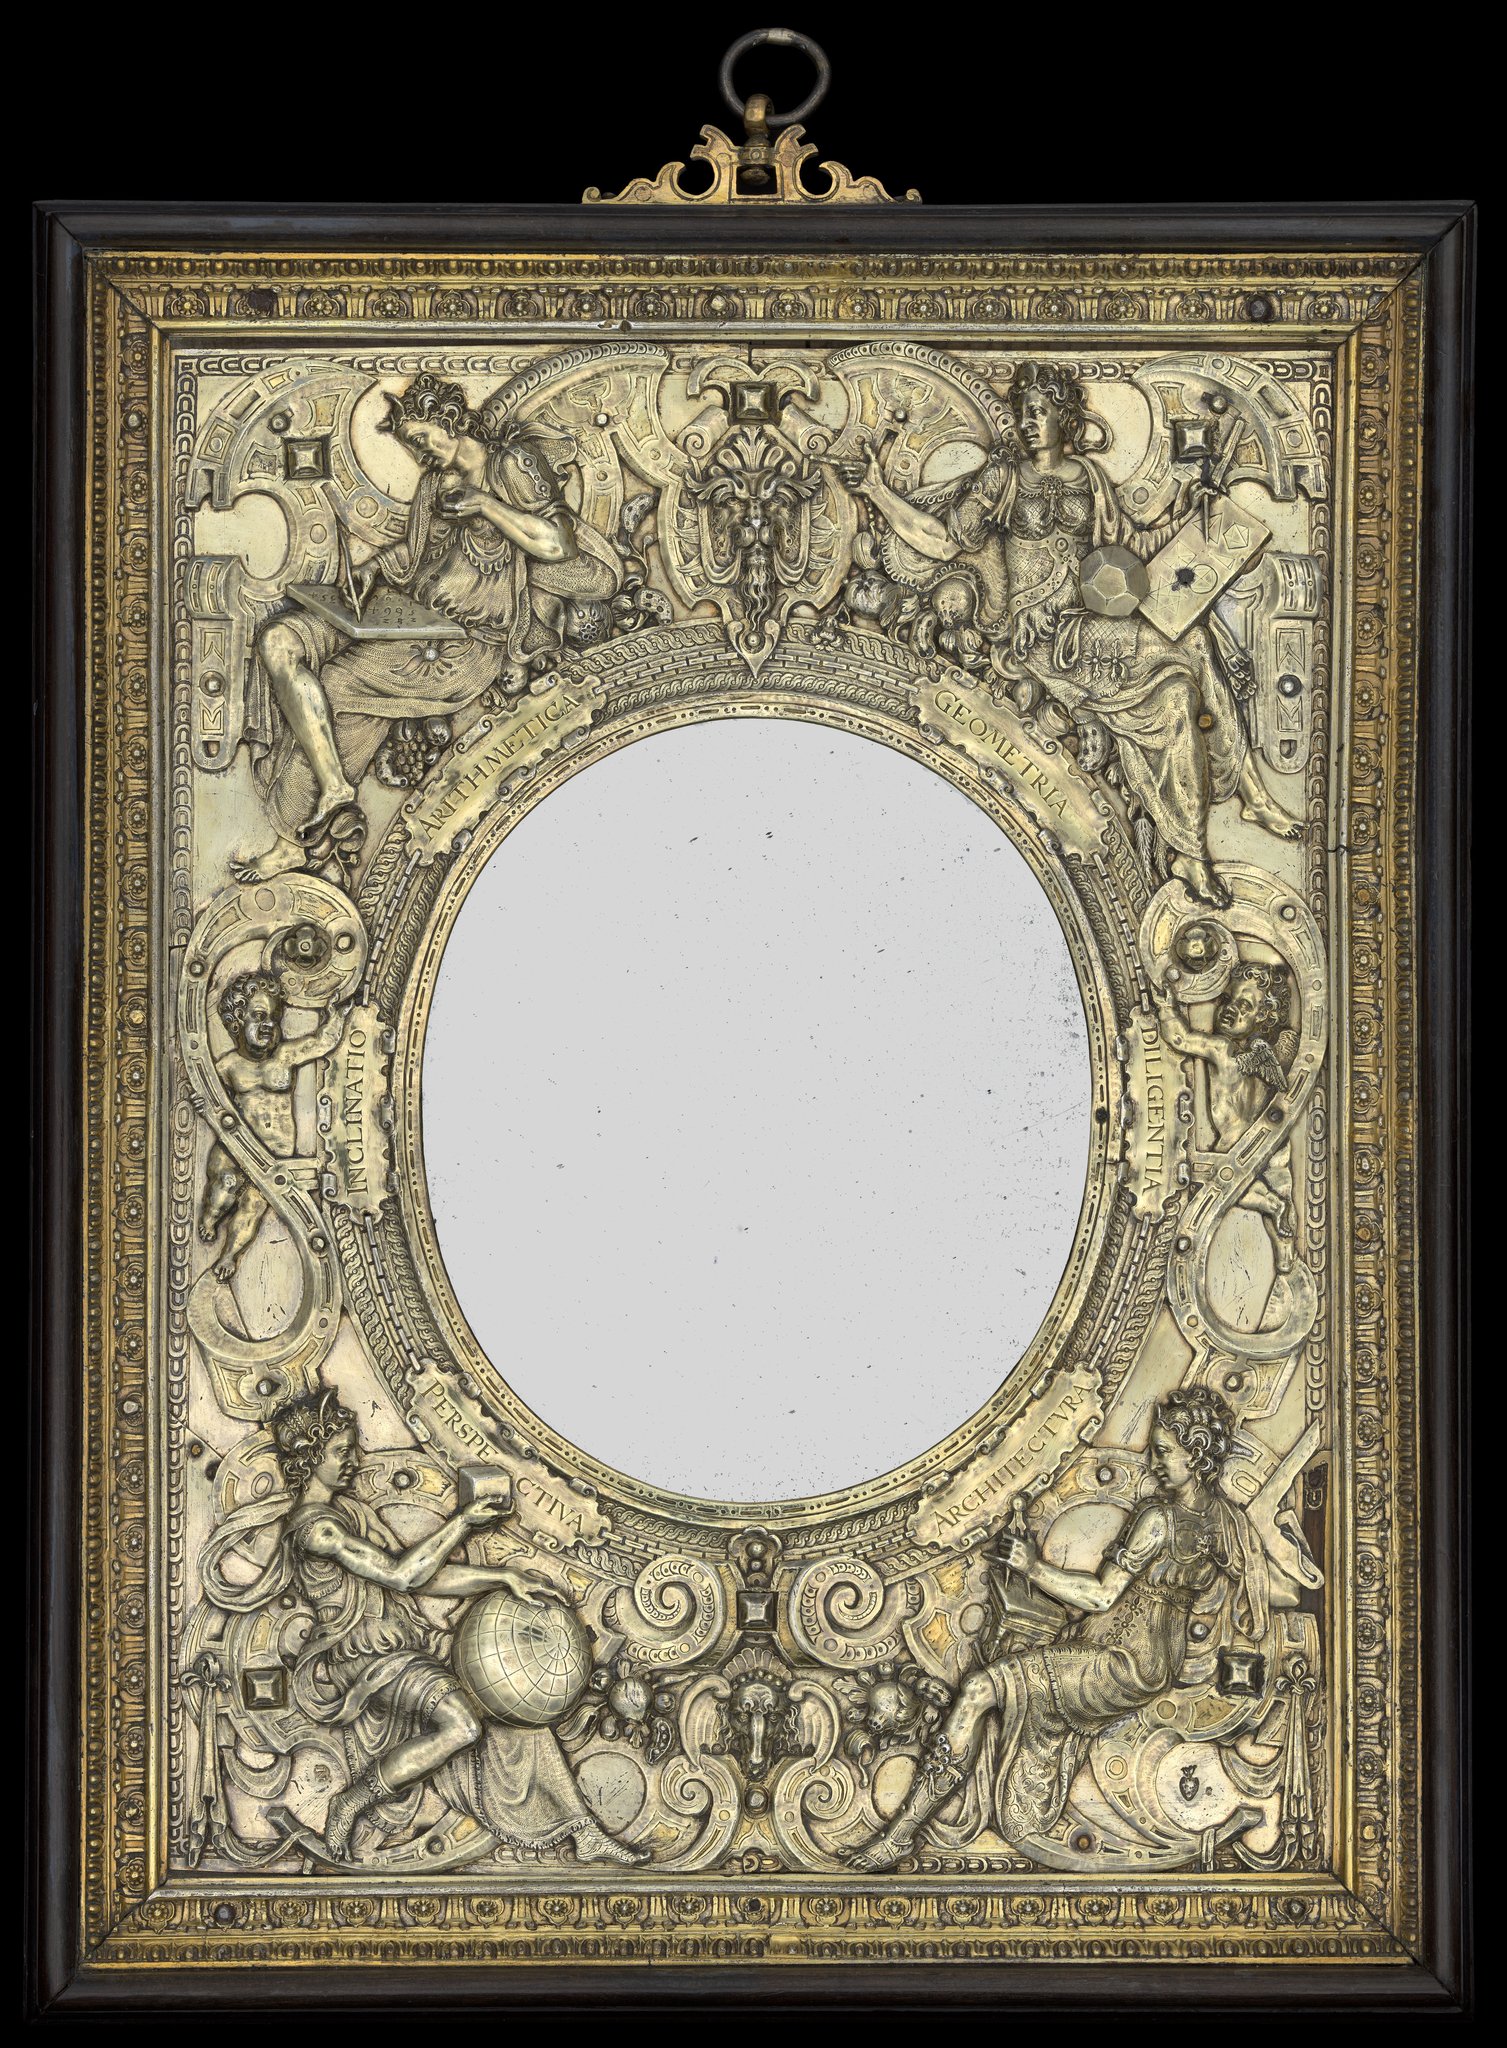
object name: mirror frame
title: Relief mounted as a mirror frame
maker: wenzel jamnitzer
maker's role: maker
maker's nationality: german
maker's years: 1507-1585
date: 1568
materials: wood, gilt silver